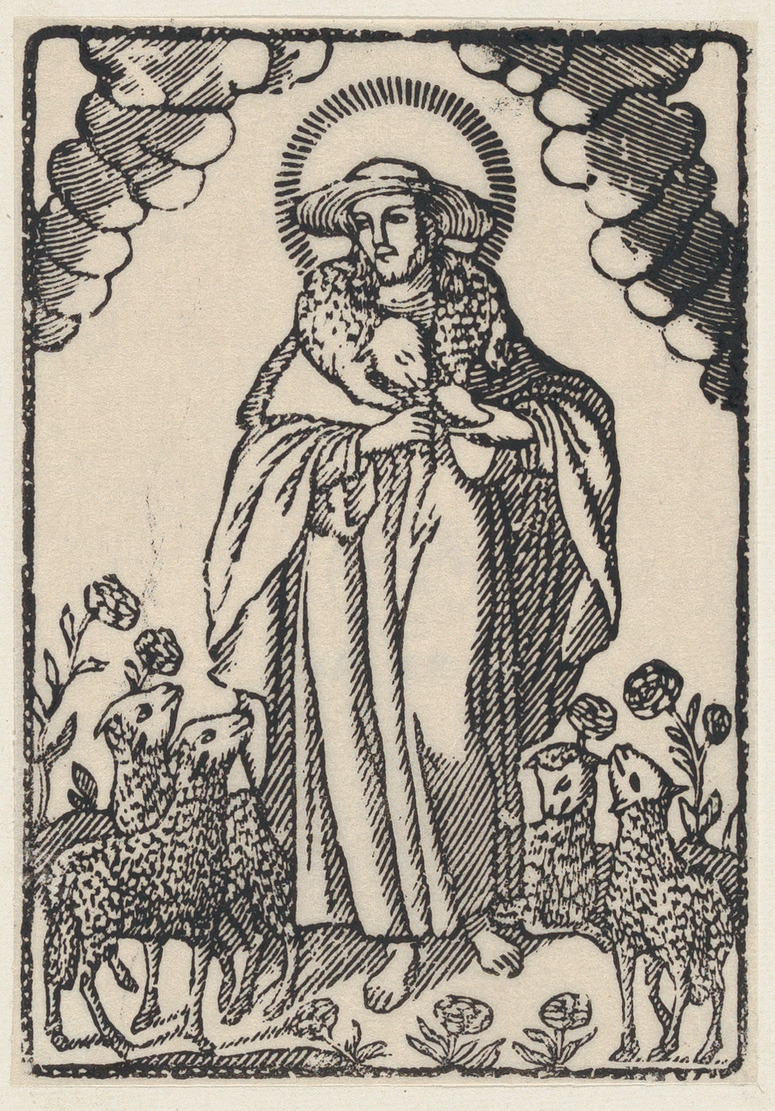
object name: print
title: The good shepherd surrounded by lambs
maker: Anonymous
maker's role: artist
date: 1801-1900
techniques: woodcut